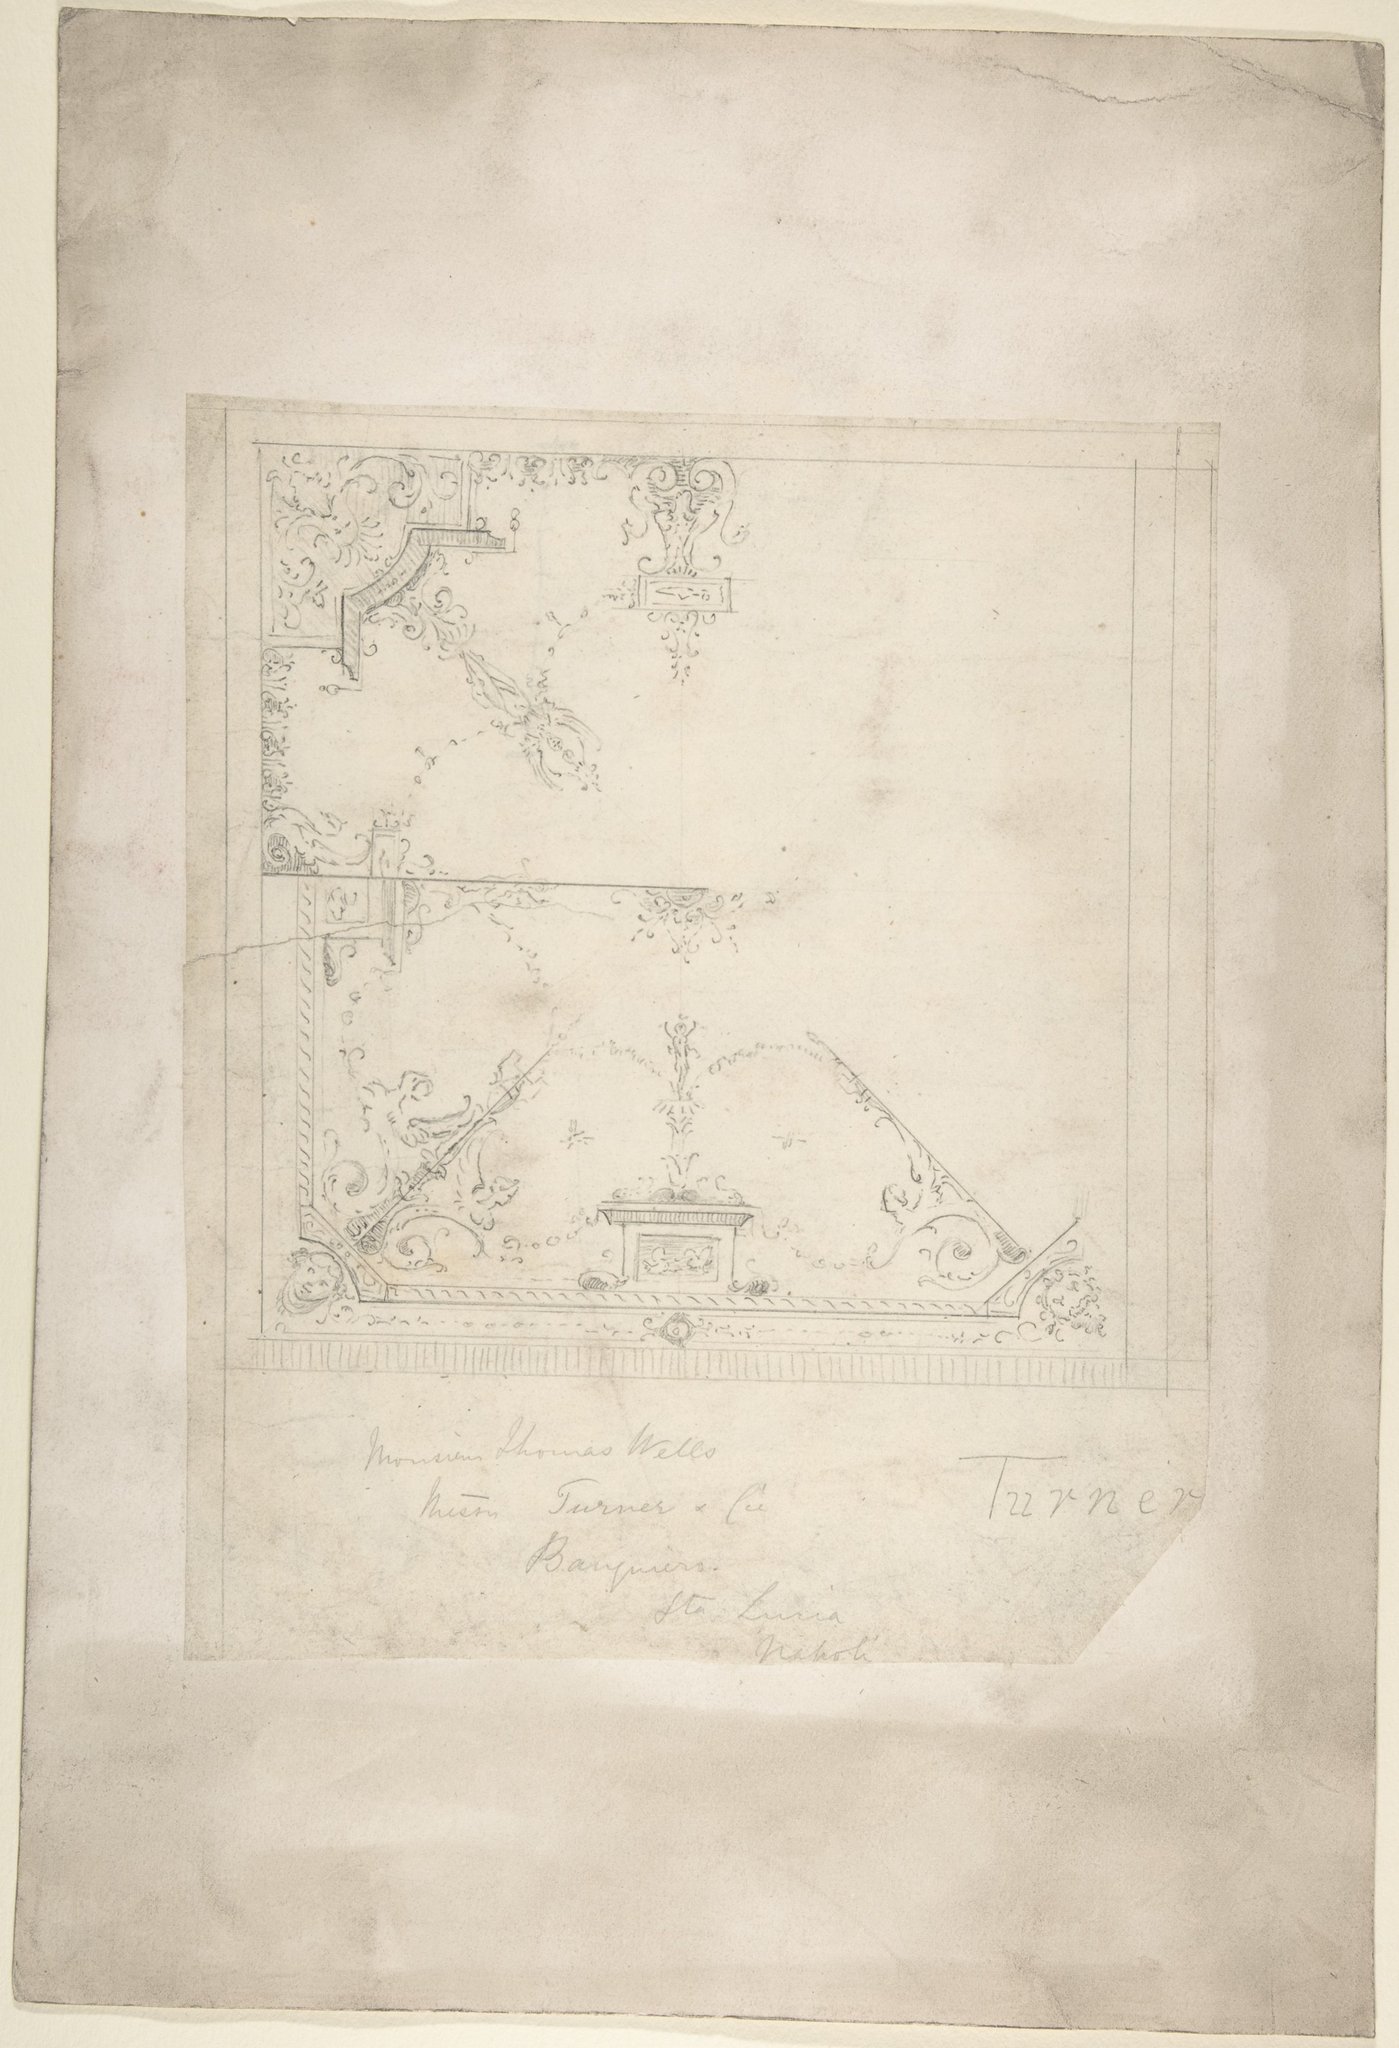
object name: drawing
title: Design for a Ceiling for Thomas Wells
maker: anonymous, british, 19th century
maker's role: artist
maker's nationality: british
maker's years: 1800-1900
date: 1801-1900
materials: graphite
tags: architecture